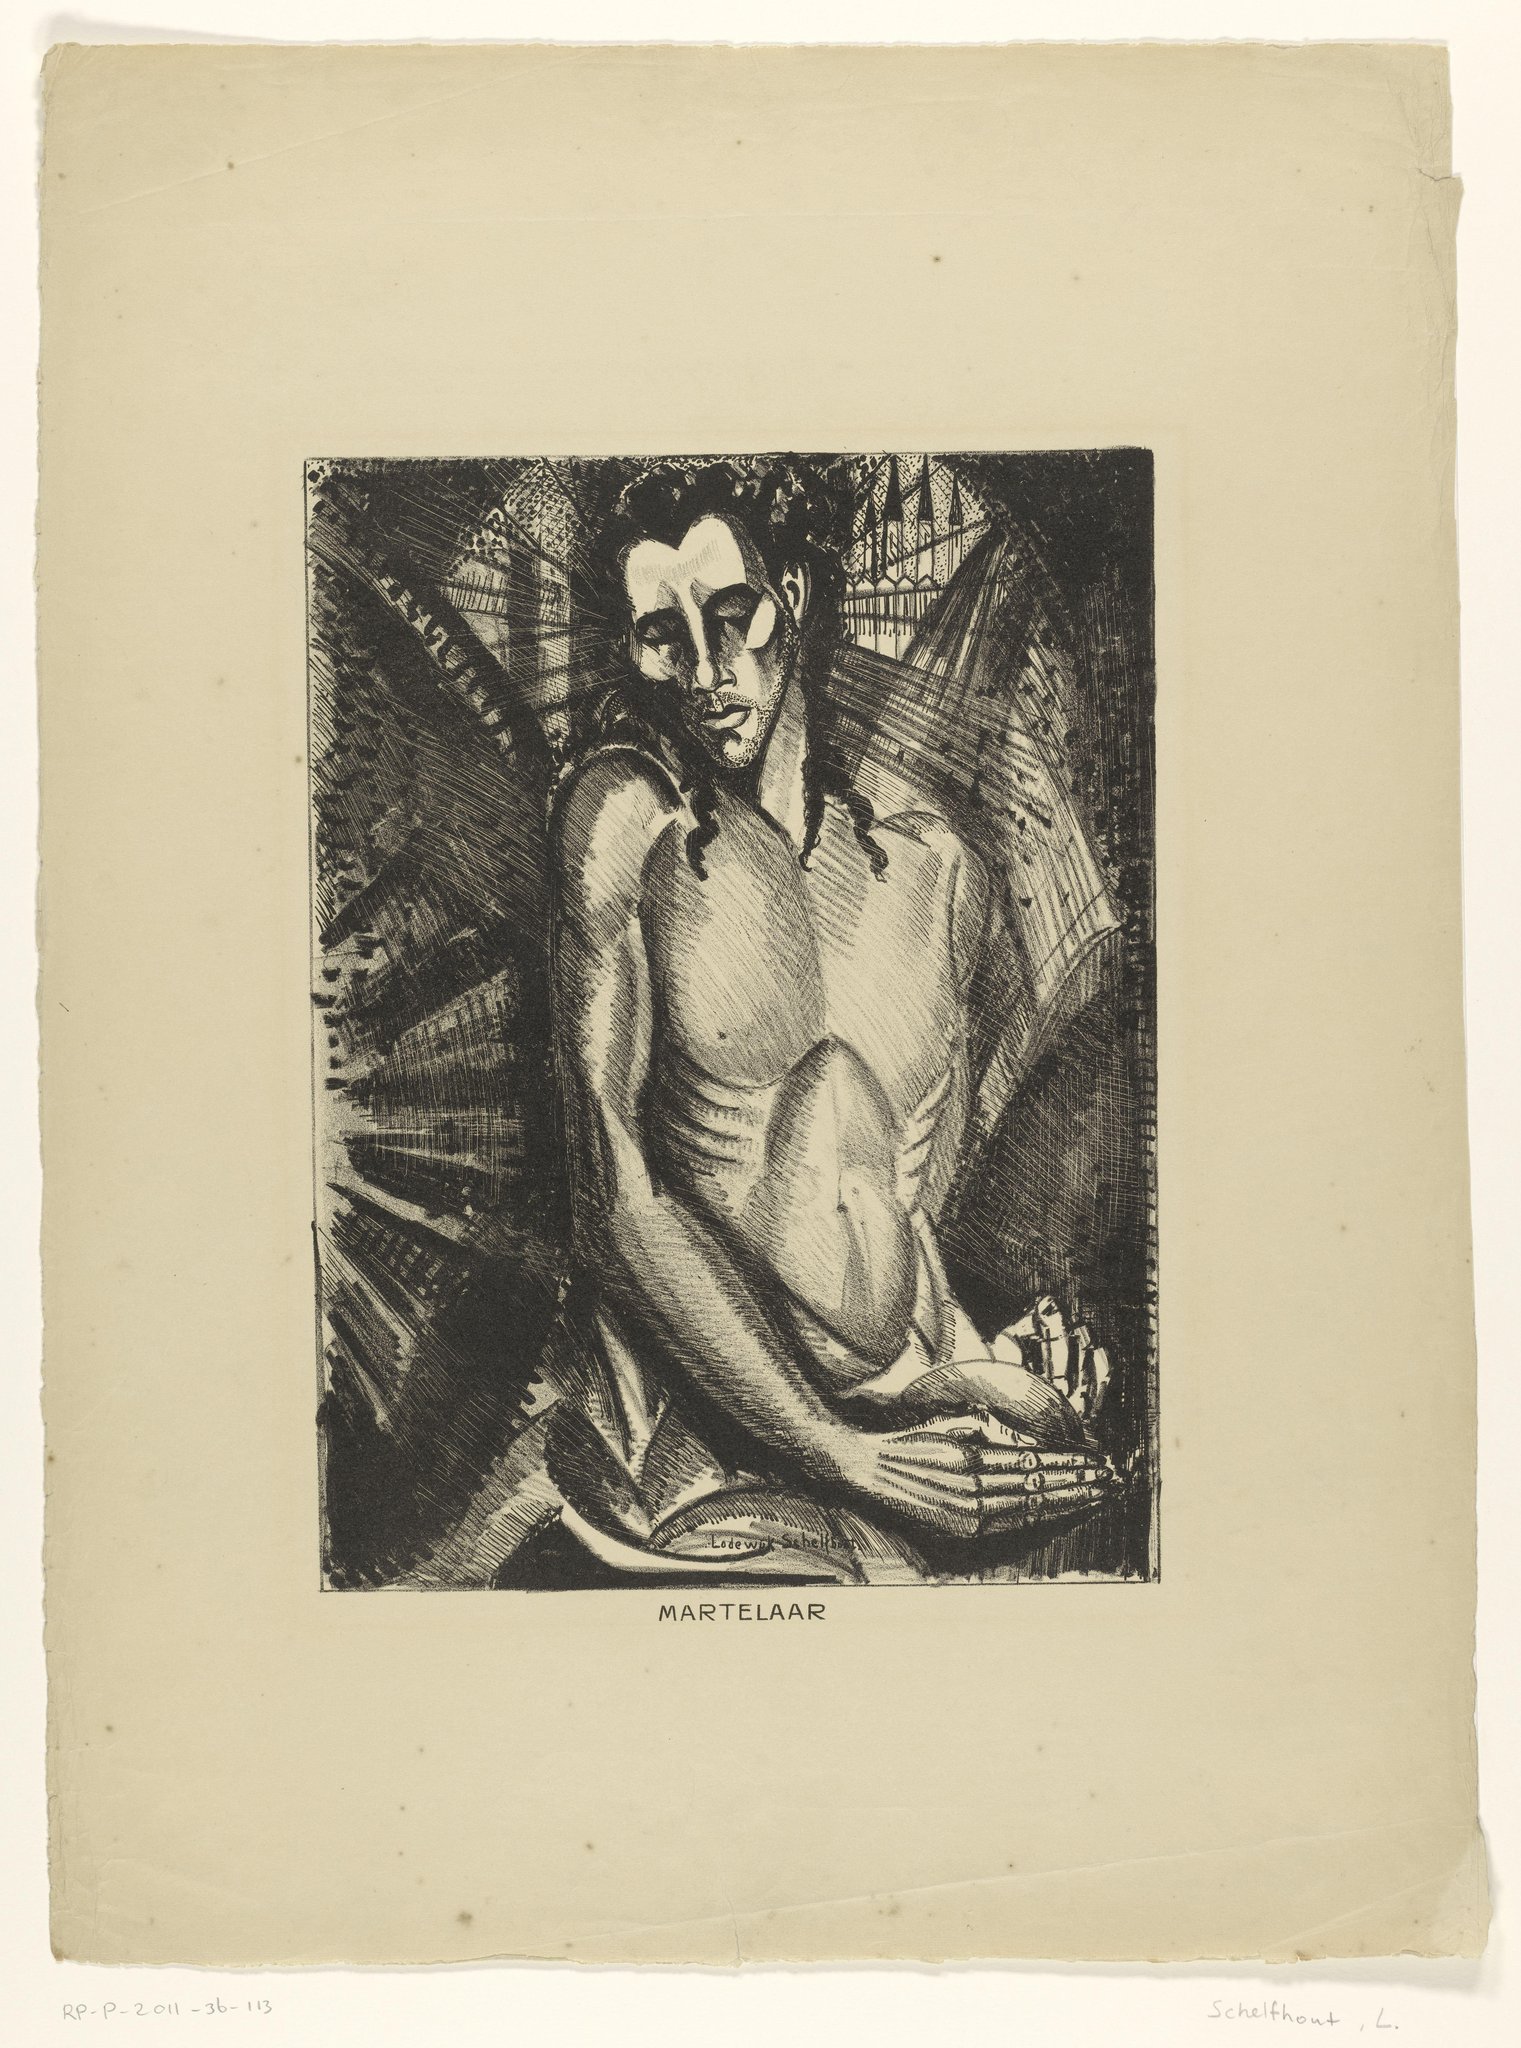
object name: print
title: Martelaar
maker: lodewijk schelfhout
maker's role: draughtsman, print maker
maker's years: 1881-1943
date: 1915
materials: paper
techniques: lithograph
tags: christ as adult, martyr(s) (often with palm-branches)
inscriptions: collector's mark: Lugt 2228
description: Prent gebruikt voor: De nieuwe Amsterdammer, Onafhankelijk Nederlandsch weekblad. Amsterdam: Maatschappij voor Goede en Goedkope Lectuur, 25 december 1915.